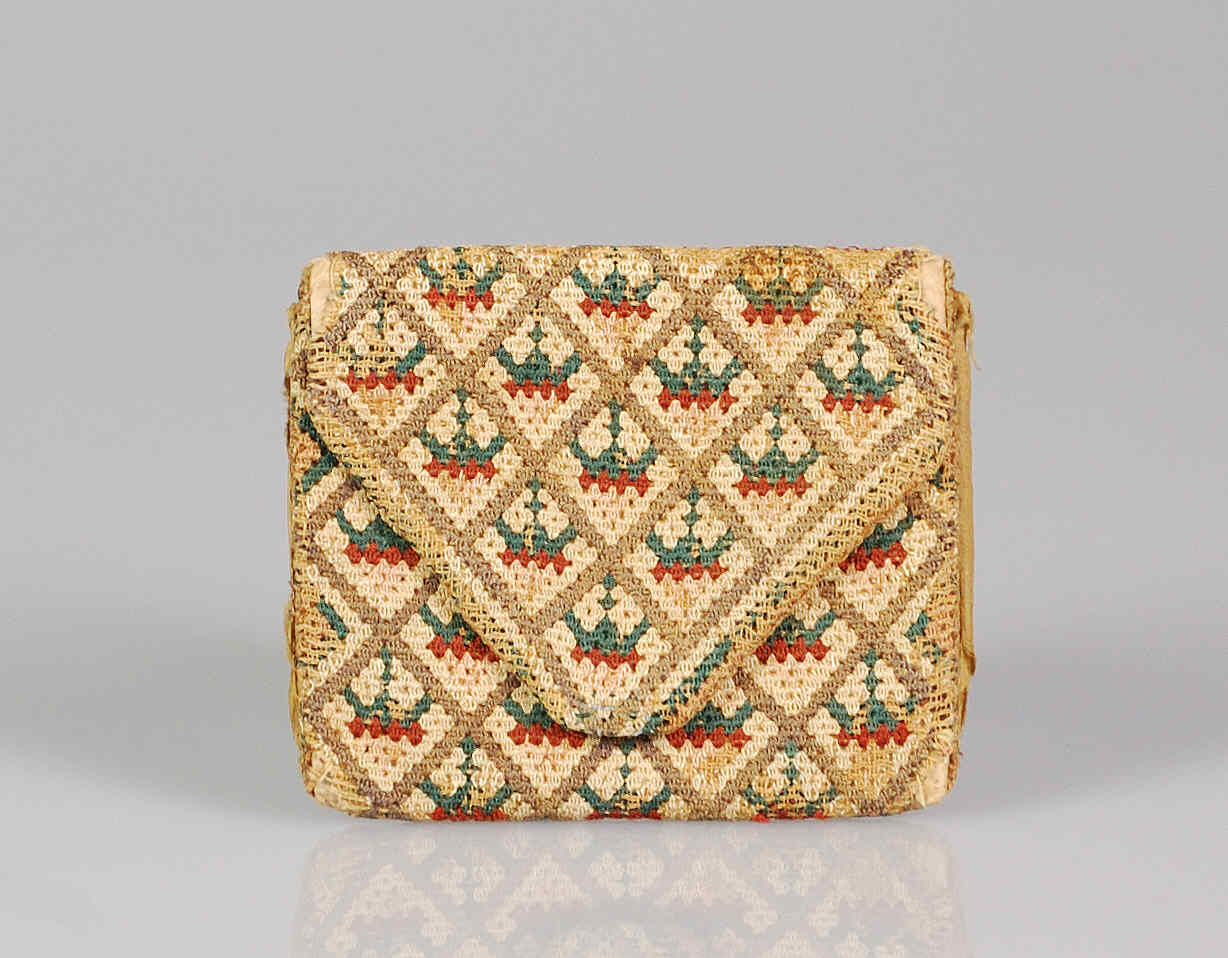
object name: purse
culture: american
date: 1790-1810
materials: linen, paper, silk